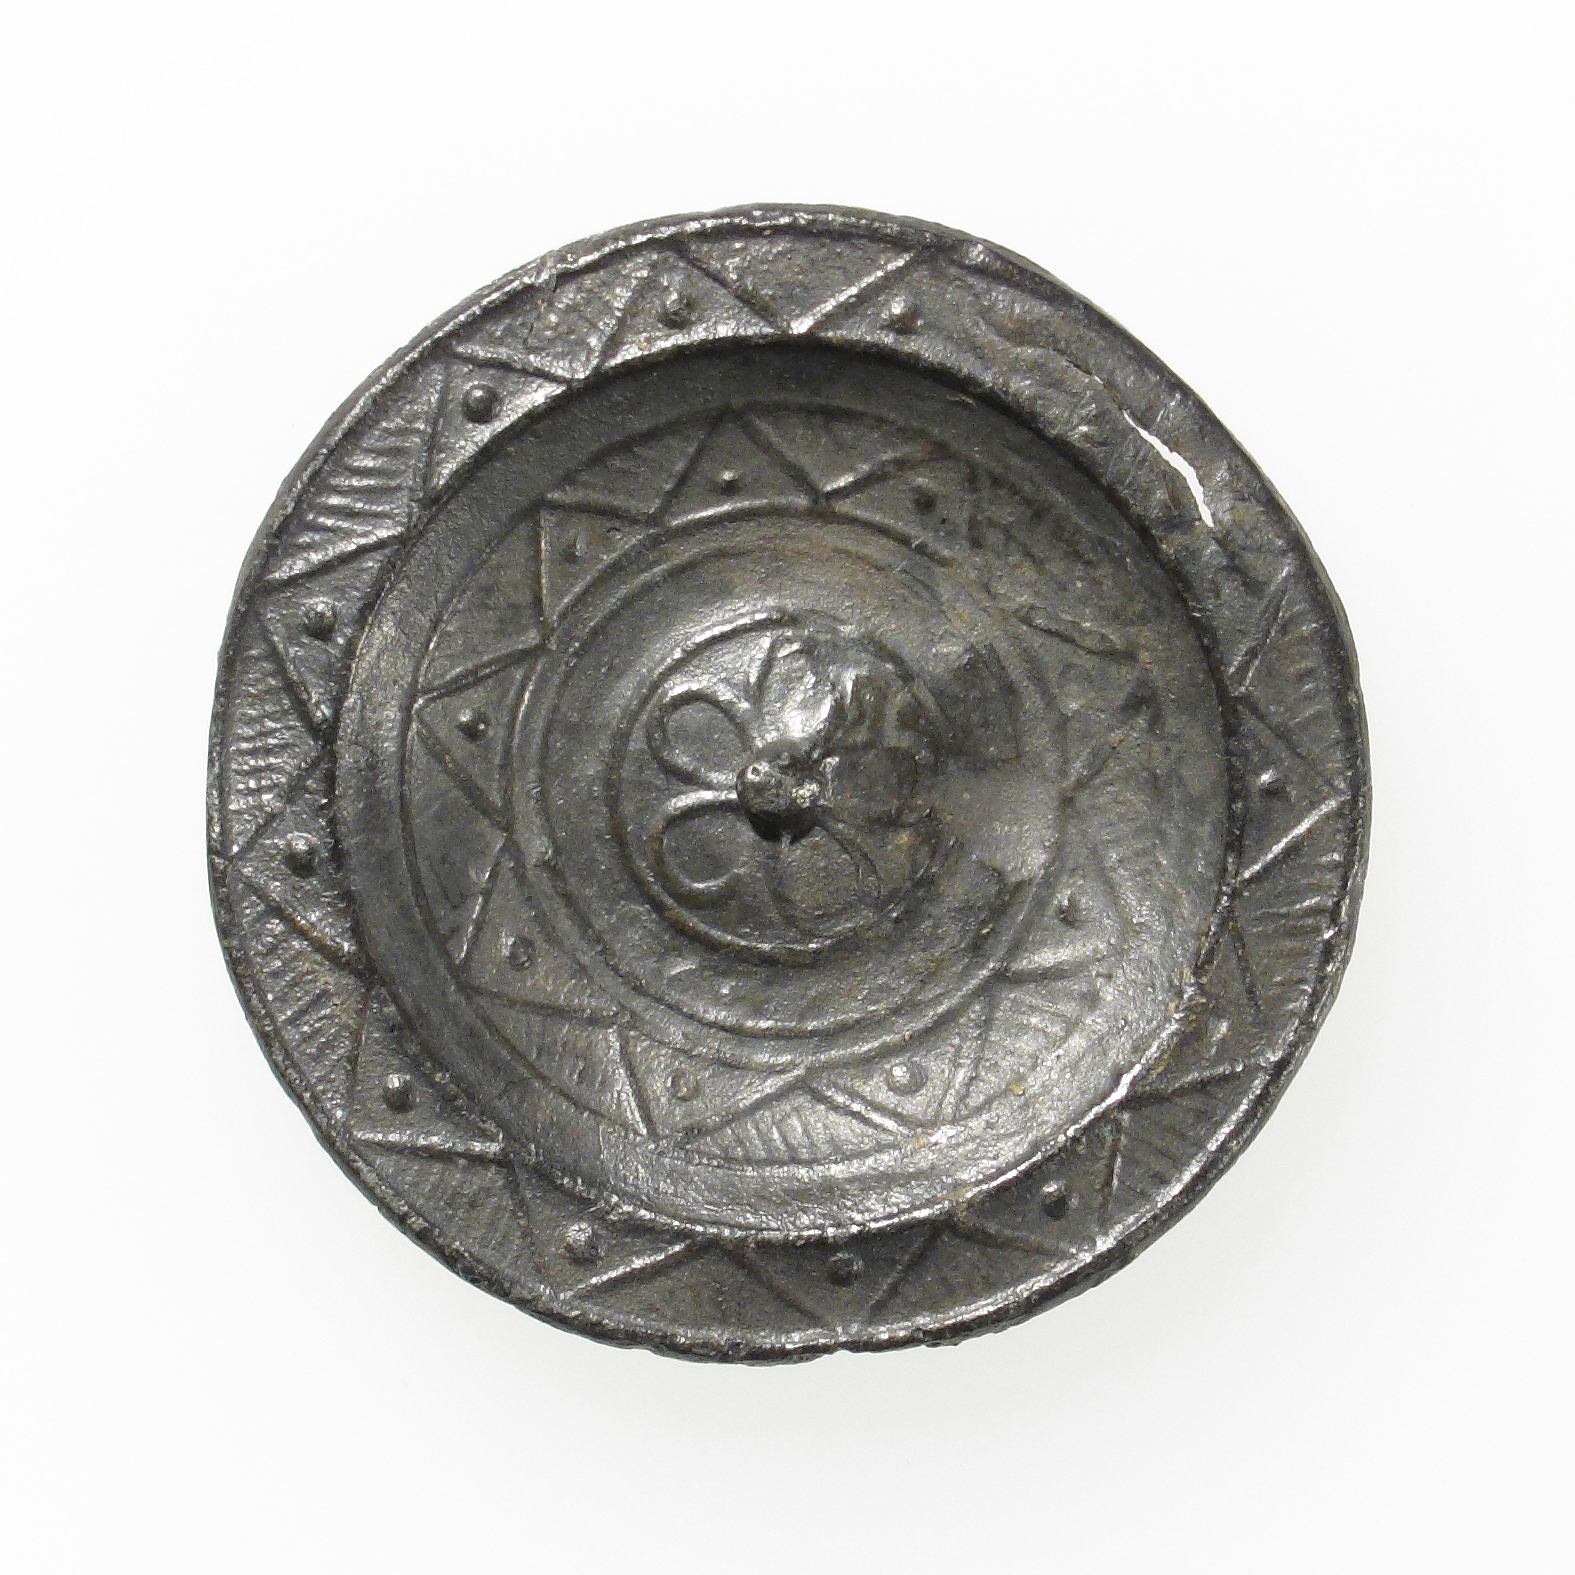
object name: pilgrim's badge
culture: french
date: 1301-1600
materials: lead